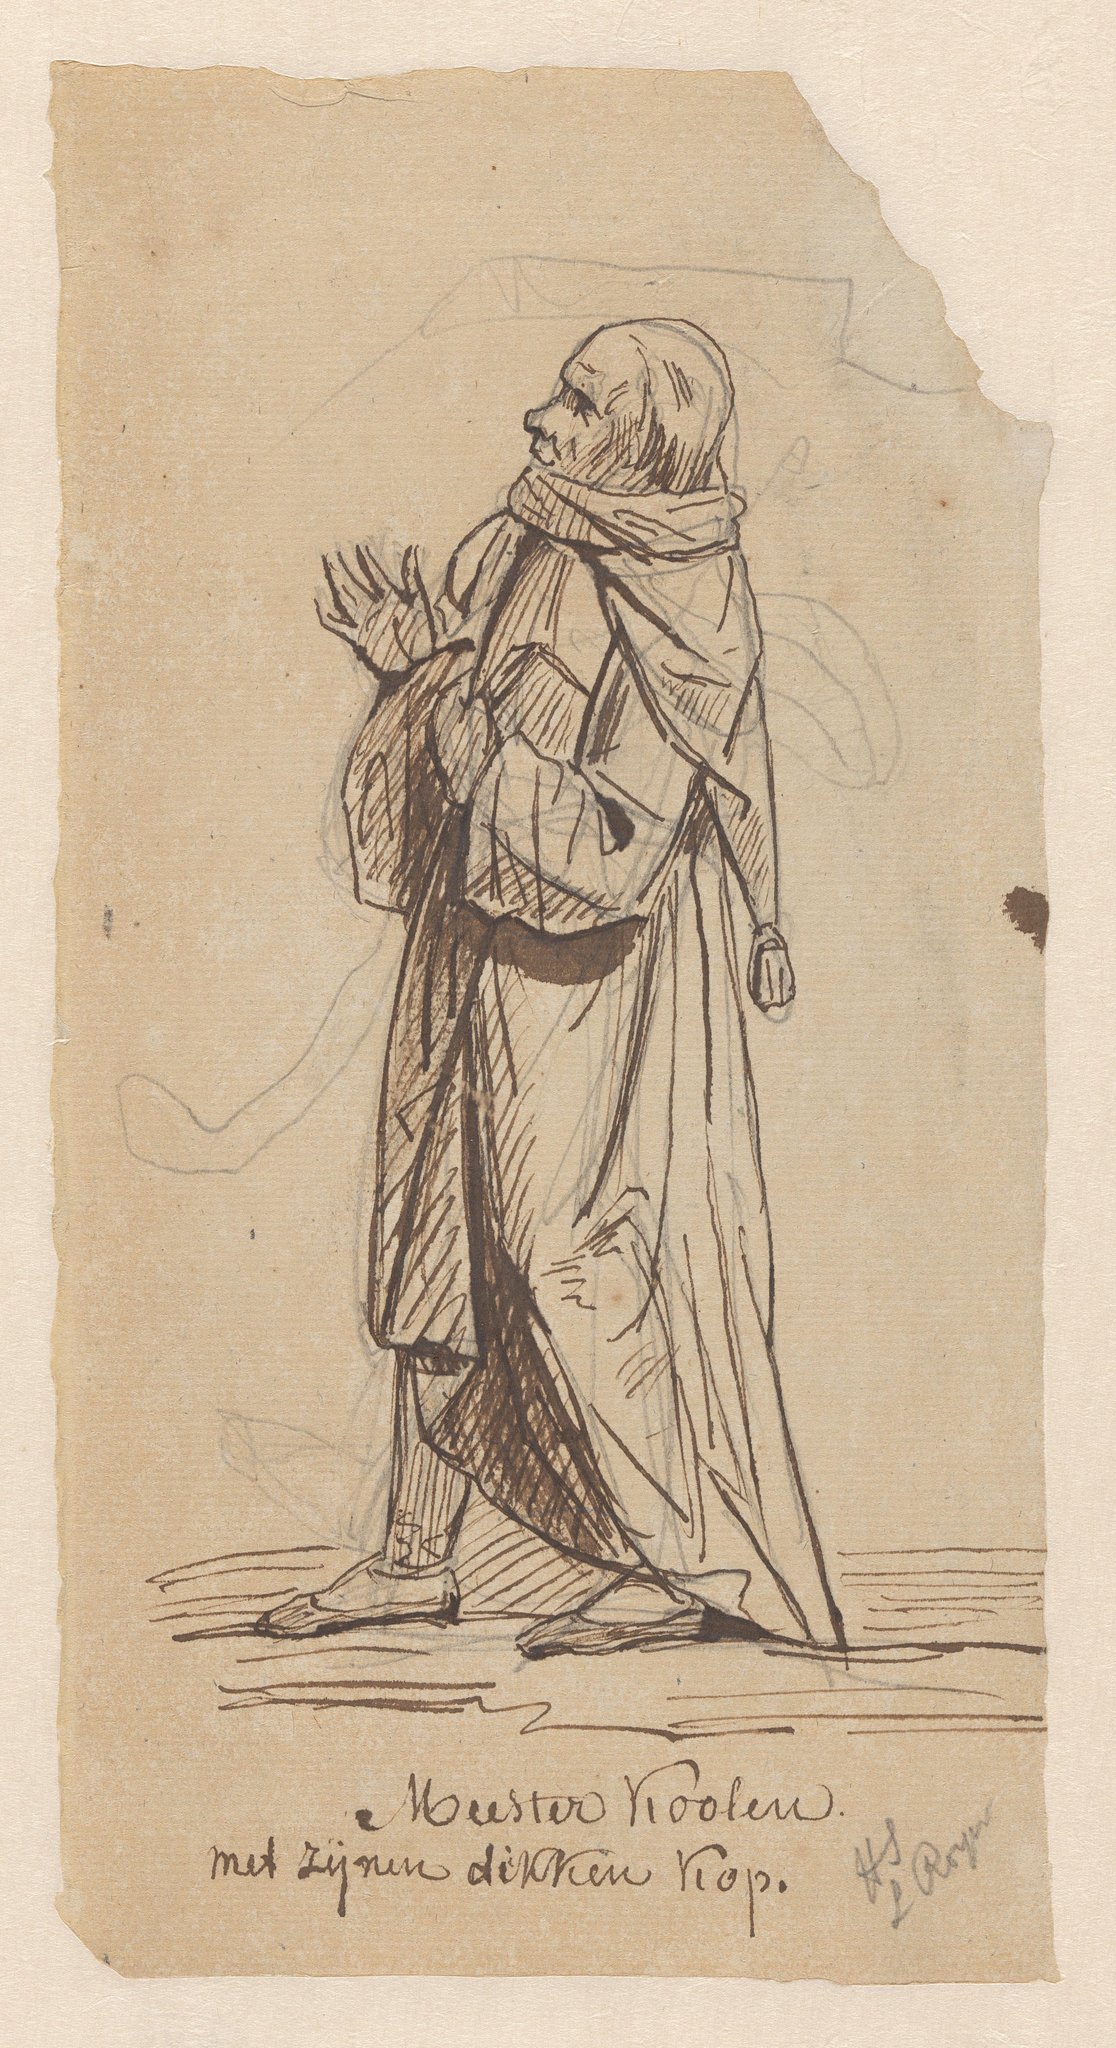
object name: drawing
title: Man in habijt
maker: louis royer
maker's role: draughtsman, sculptor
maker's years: 1793-1868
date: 1803-1868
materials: ink, paper, pencil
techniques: writing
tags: scholastic education, tuition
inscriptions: inscription: ‘Meester Koolen / met zijnen dikken kop.’, inscription: ‘HJ [?] / L Royer’